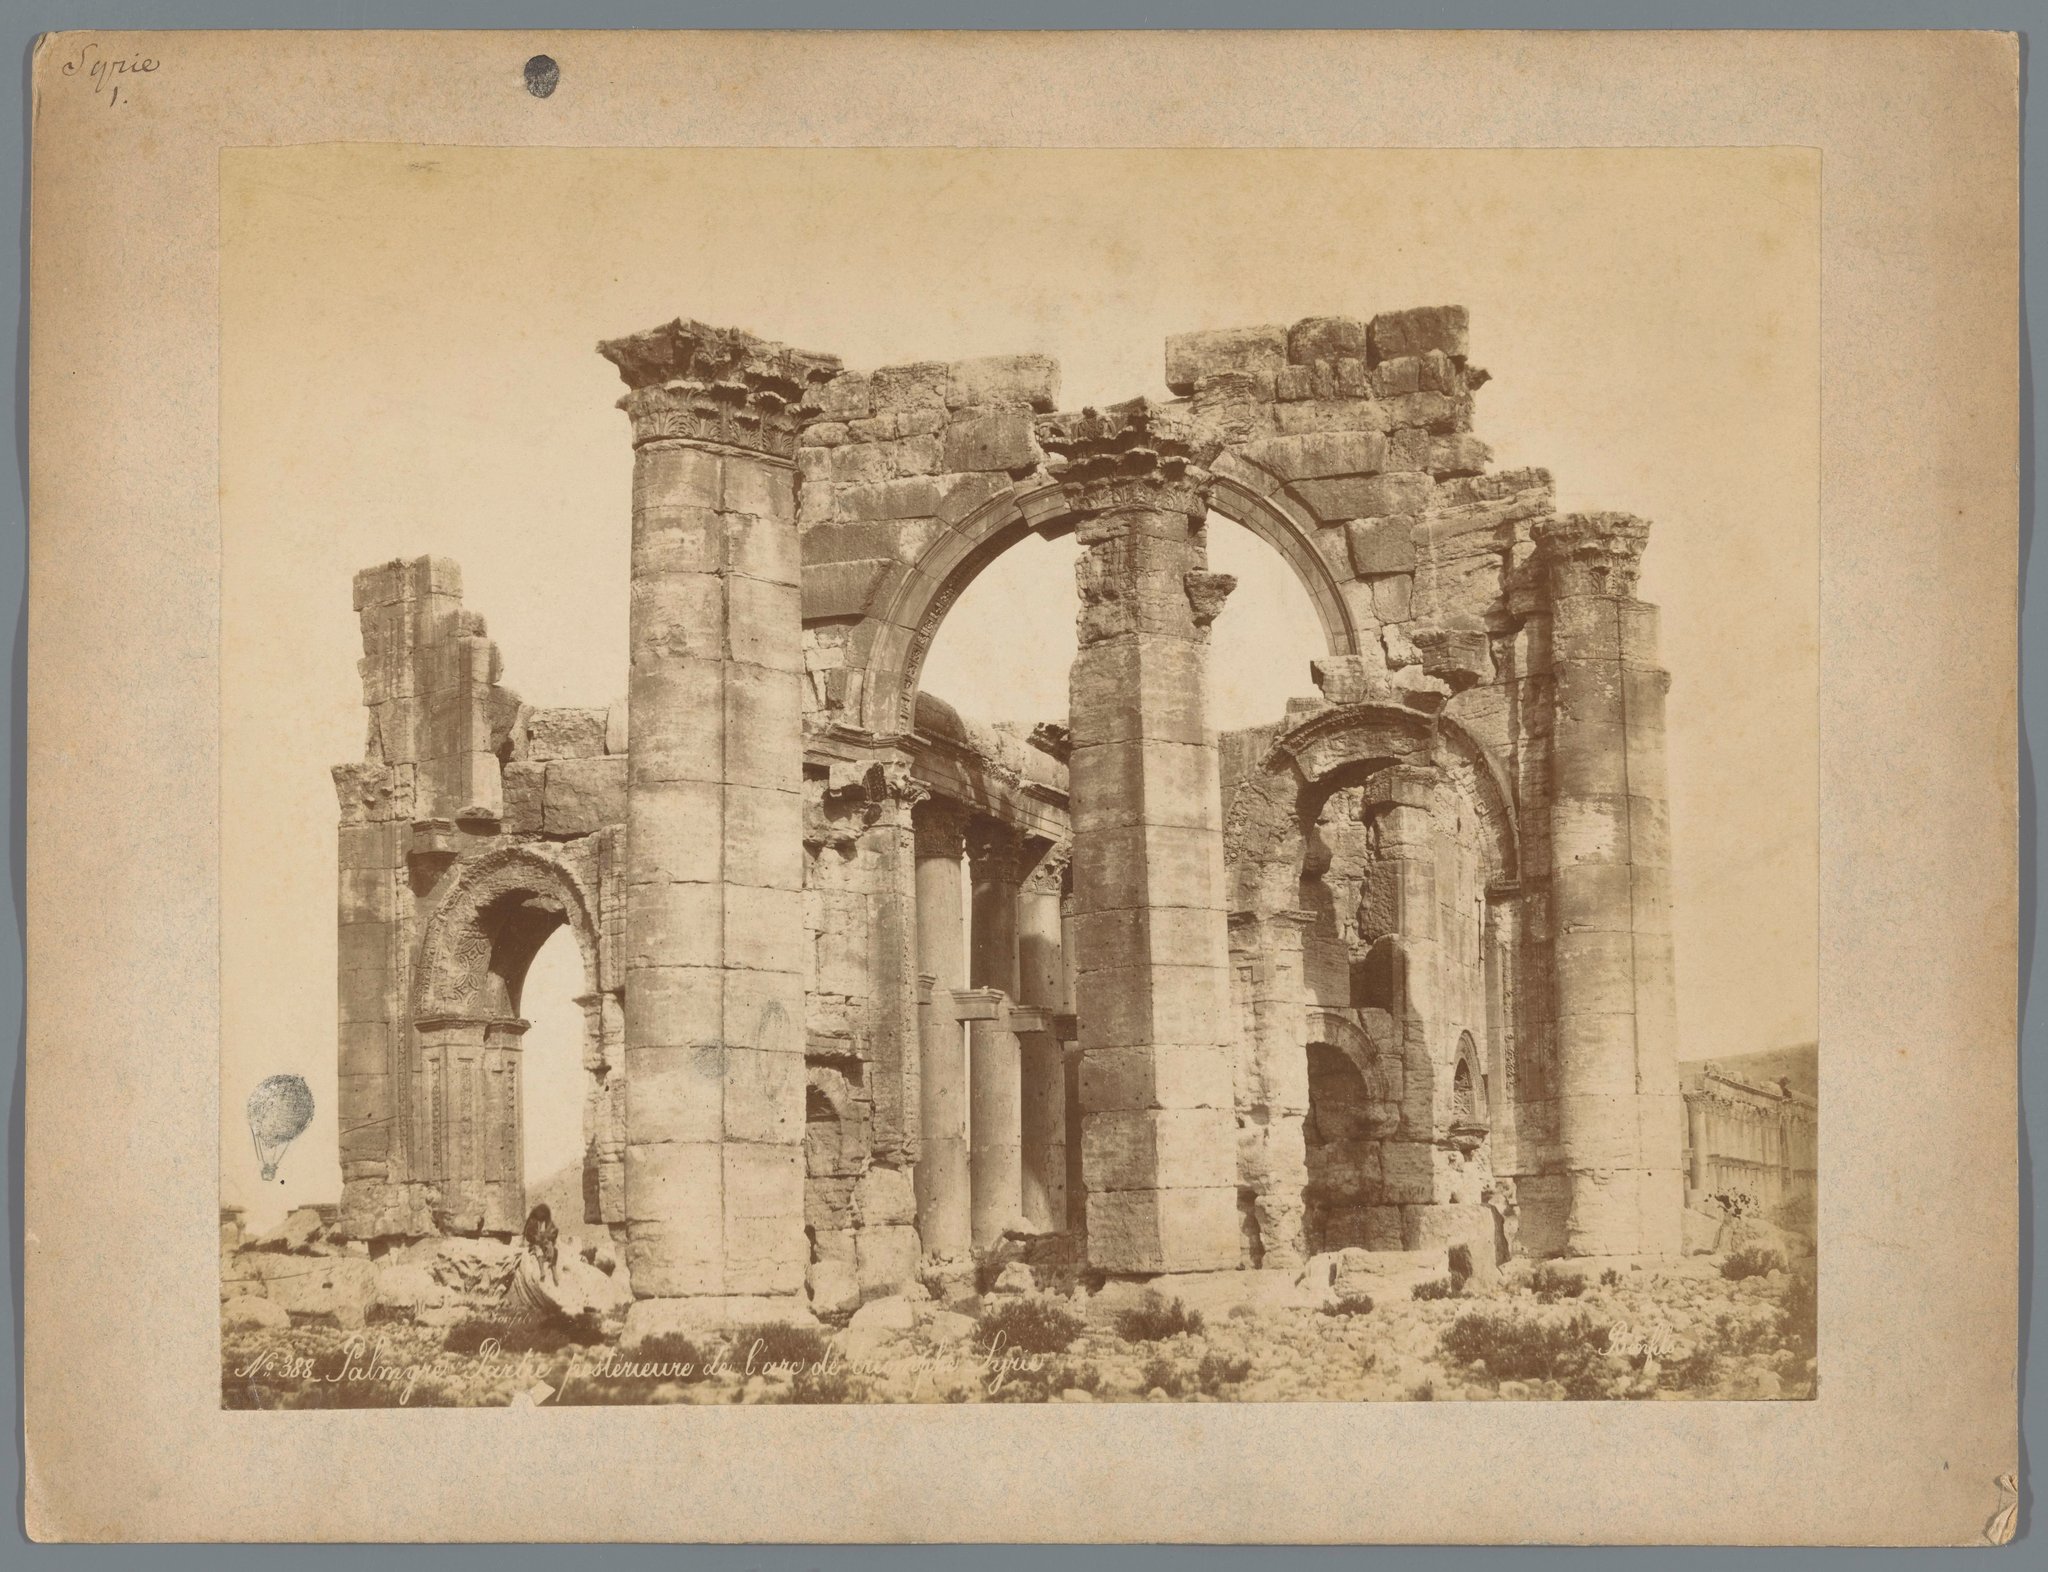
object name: photograph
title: Palmyre. Partie postérieure de l'arc de triomphe Syrie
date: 1875-1900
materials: cardboard, photographic support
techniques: albumen print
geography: palmyra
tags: column, pillar ~ architecture, ruin of a building ~ architecture, triumphal arch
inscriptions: annotation, collector's mark: ‘RIJKS-NORMAALSCHOOL voor TEEKENONDERWIJZERS AMSTERDAM’, number: ‘No. 388’, inscription: ‘Syrie 1.’